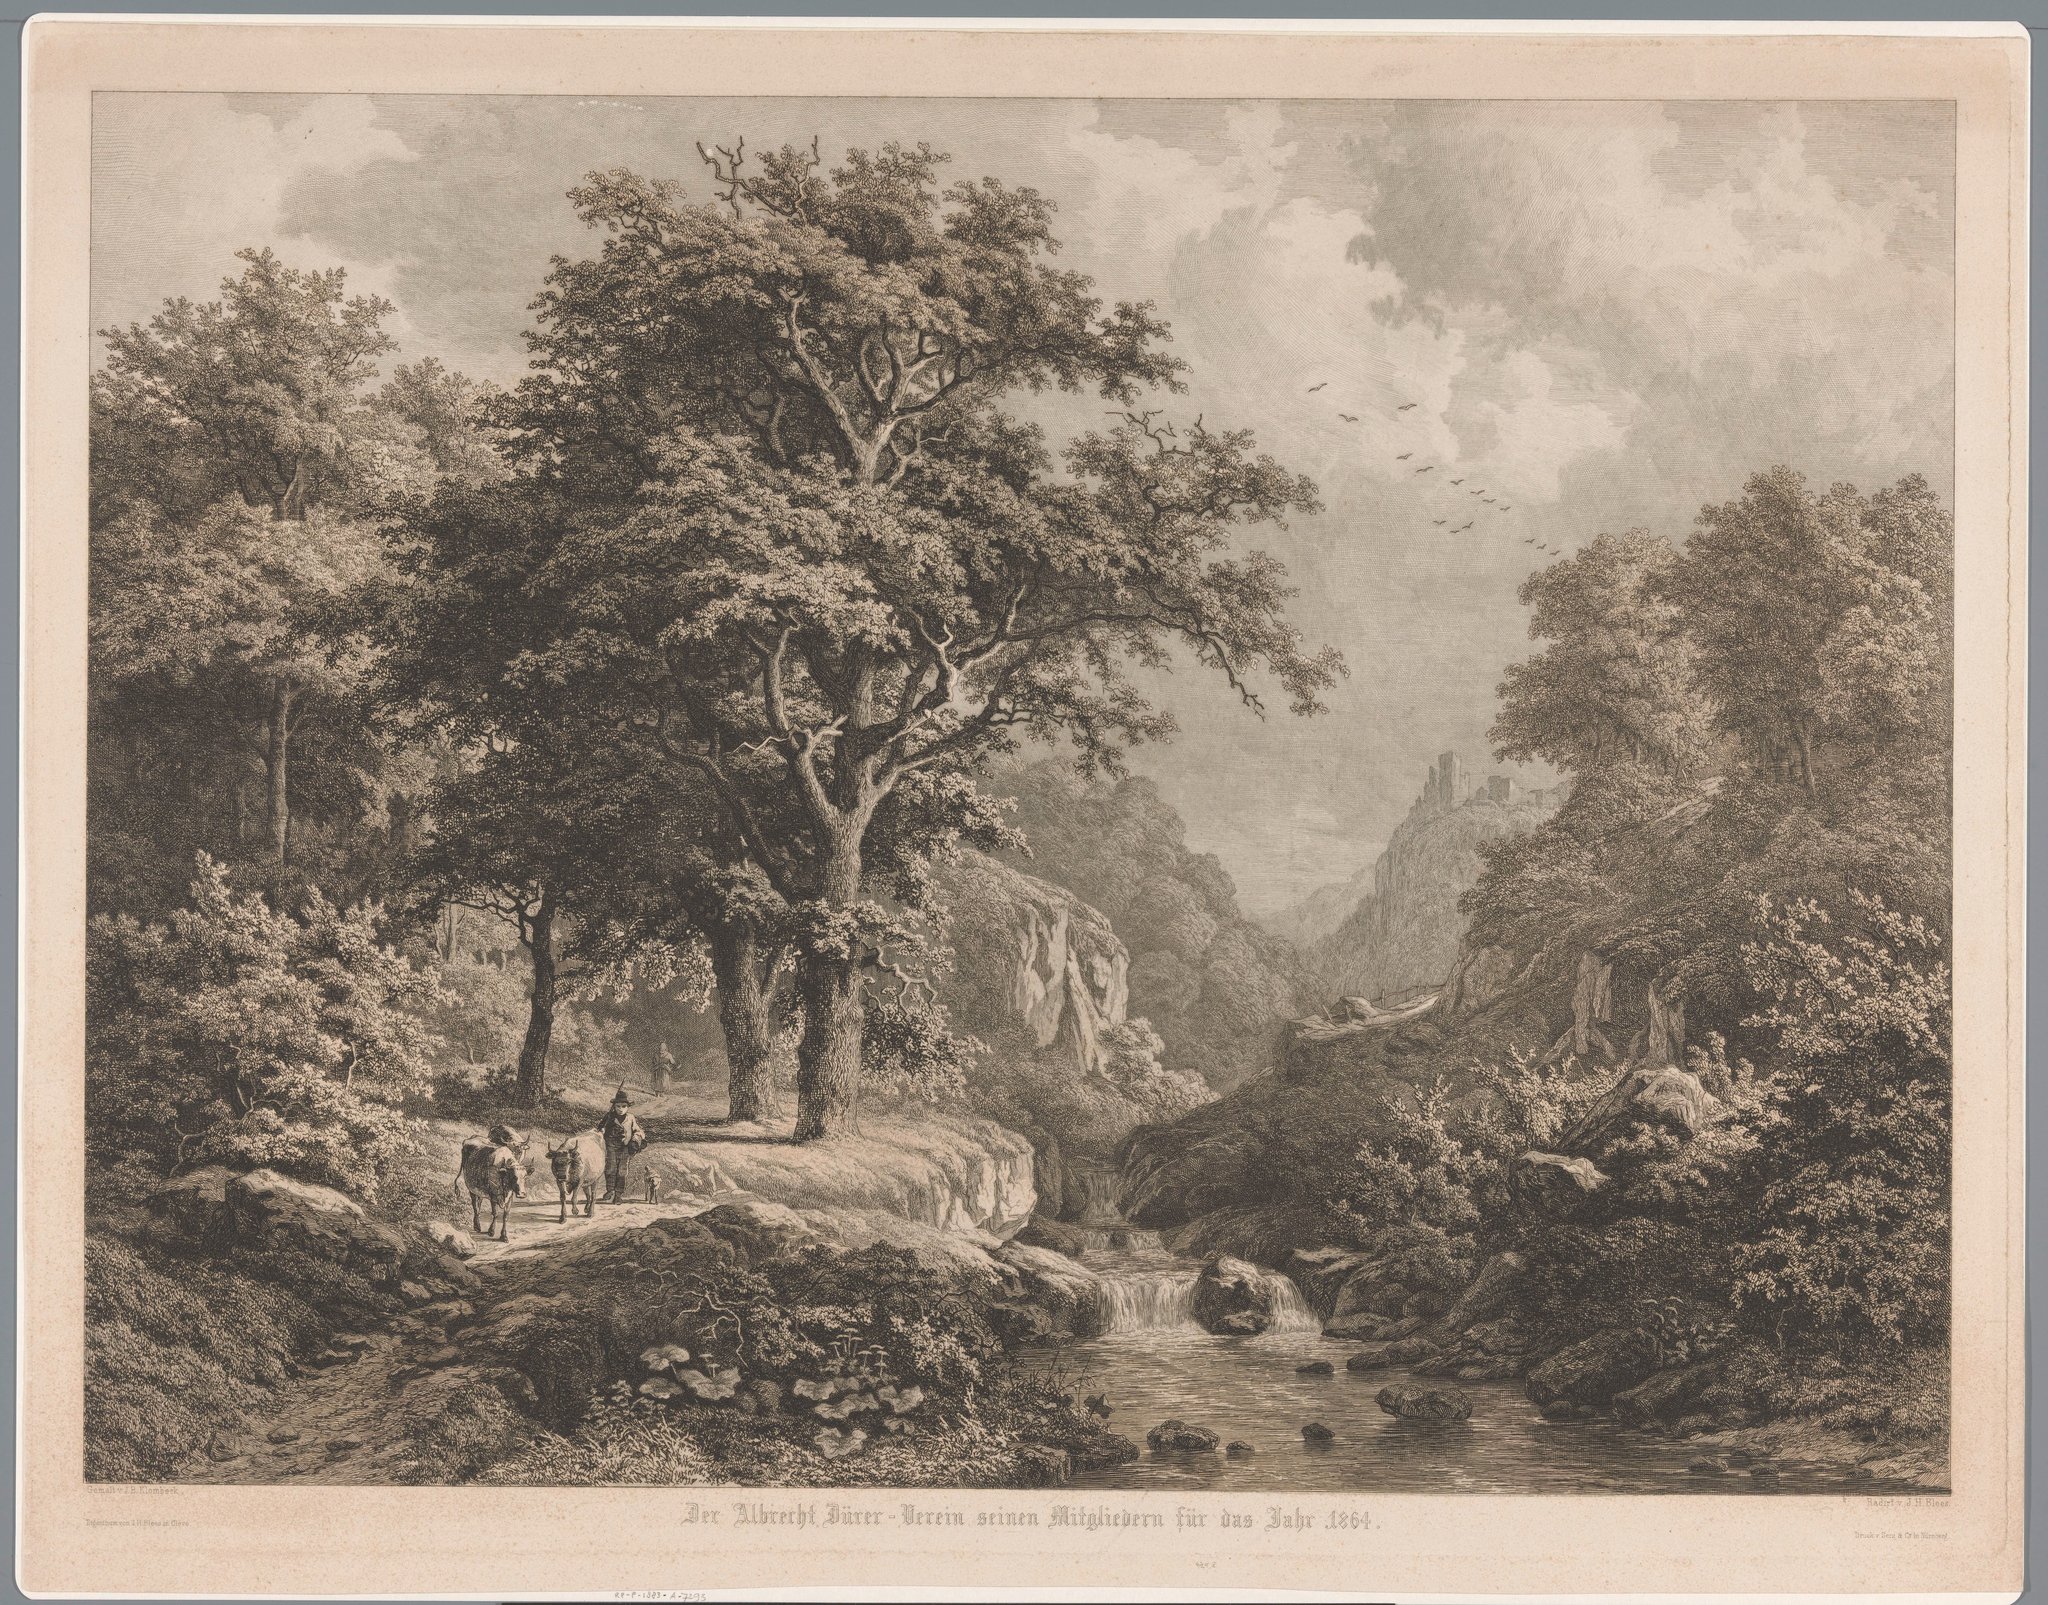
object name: print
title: Bergachtig landschap met in het midden een waterval, links een jongen met drie koeien en een hond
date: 1864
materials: paper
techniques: etching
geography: nuremberg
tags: cow, herding, herdsman, herdswoman, shepherd, shepherdess, cowherd, etc., waterfall, forest, wood, dog, mountains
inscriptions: collector's mark: Lugt 2228